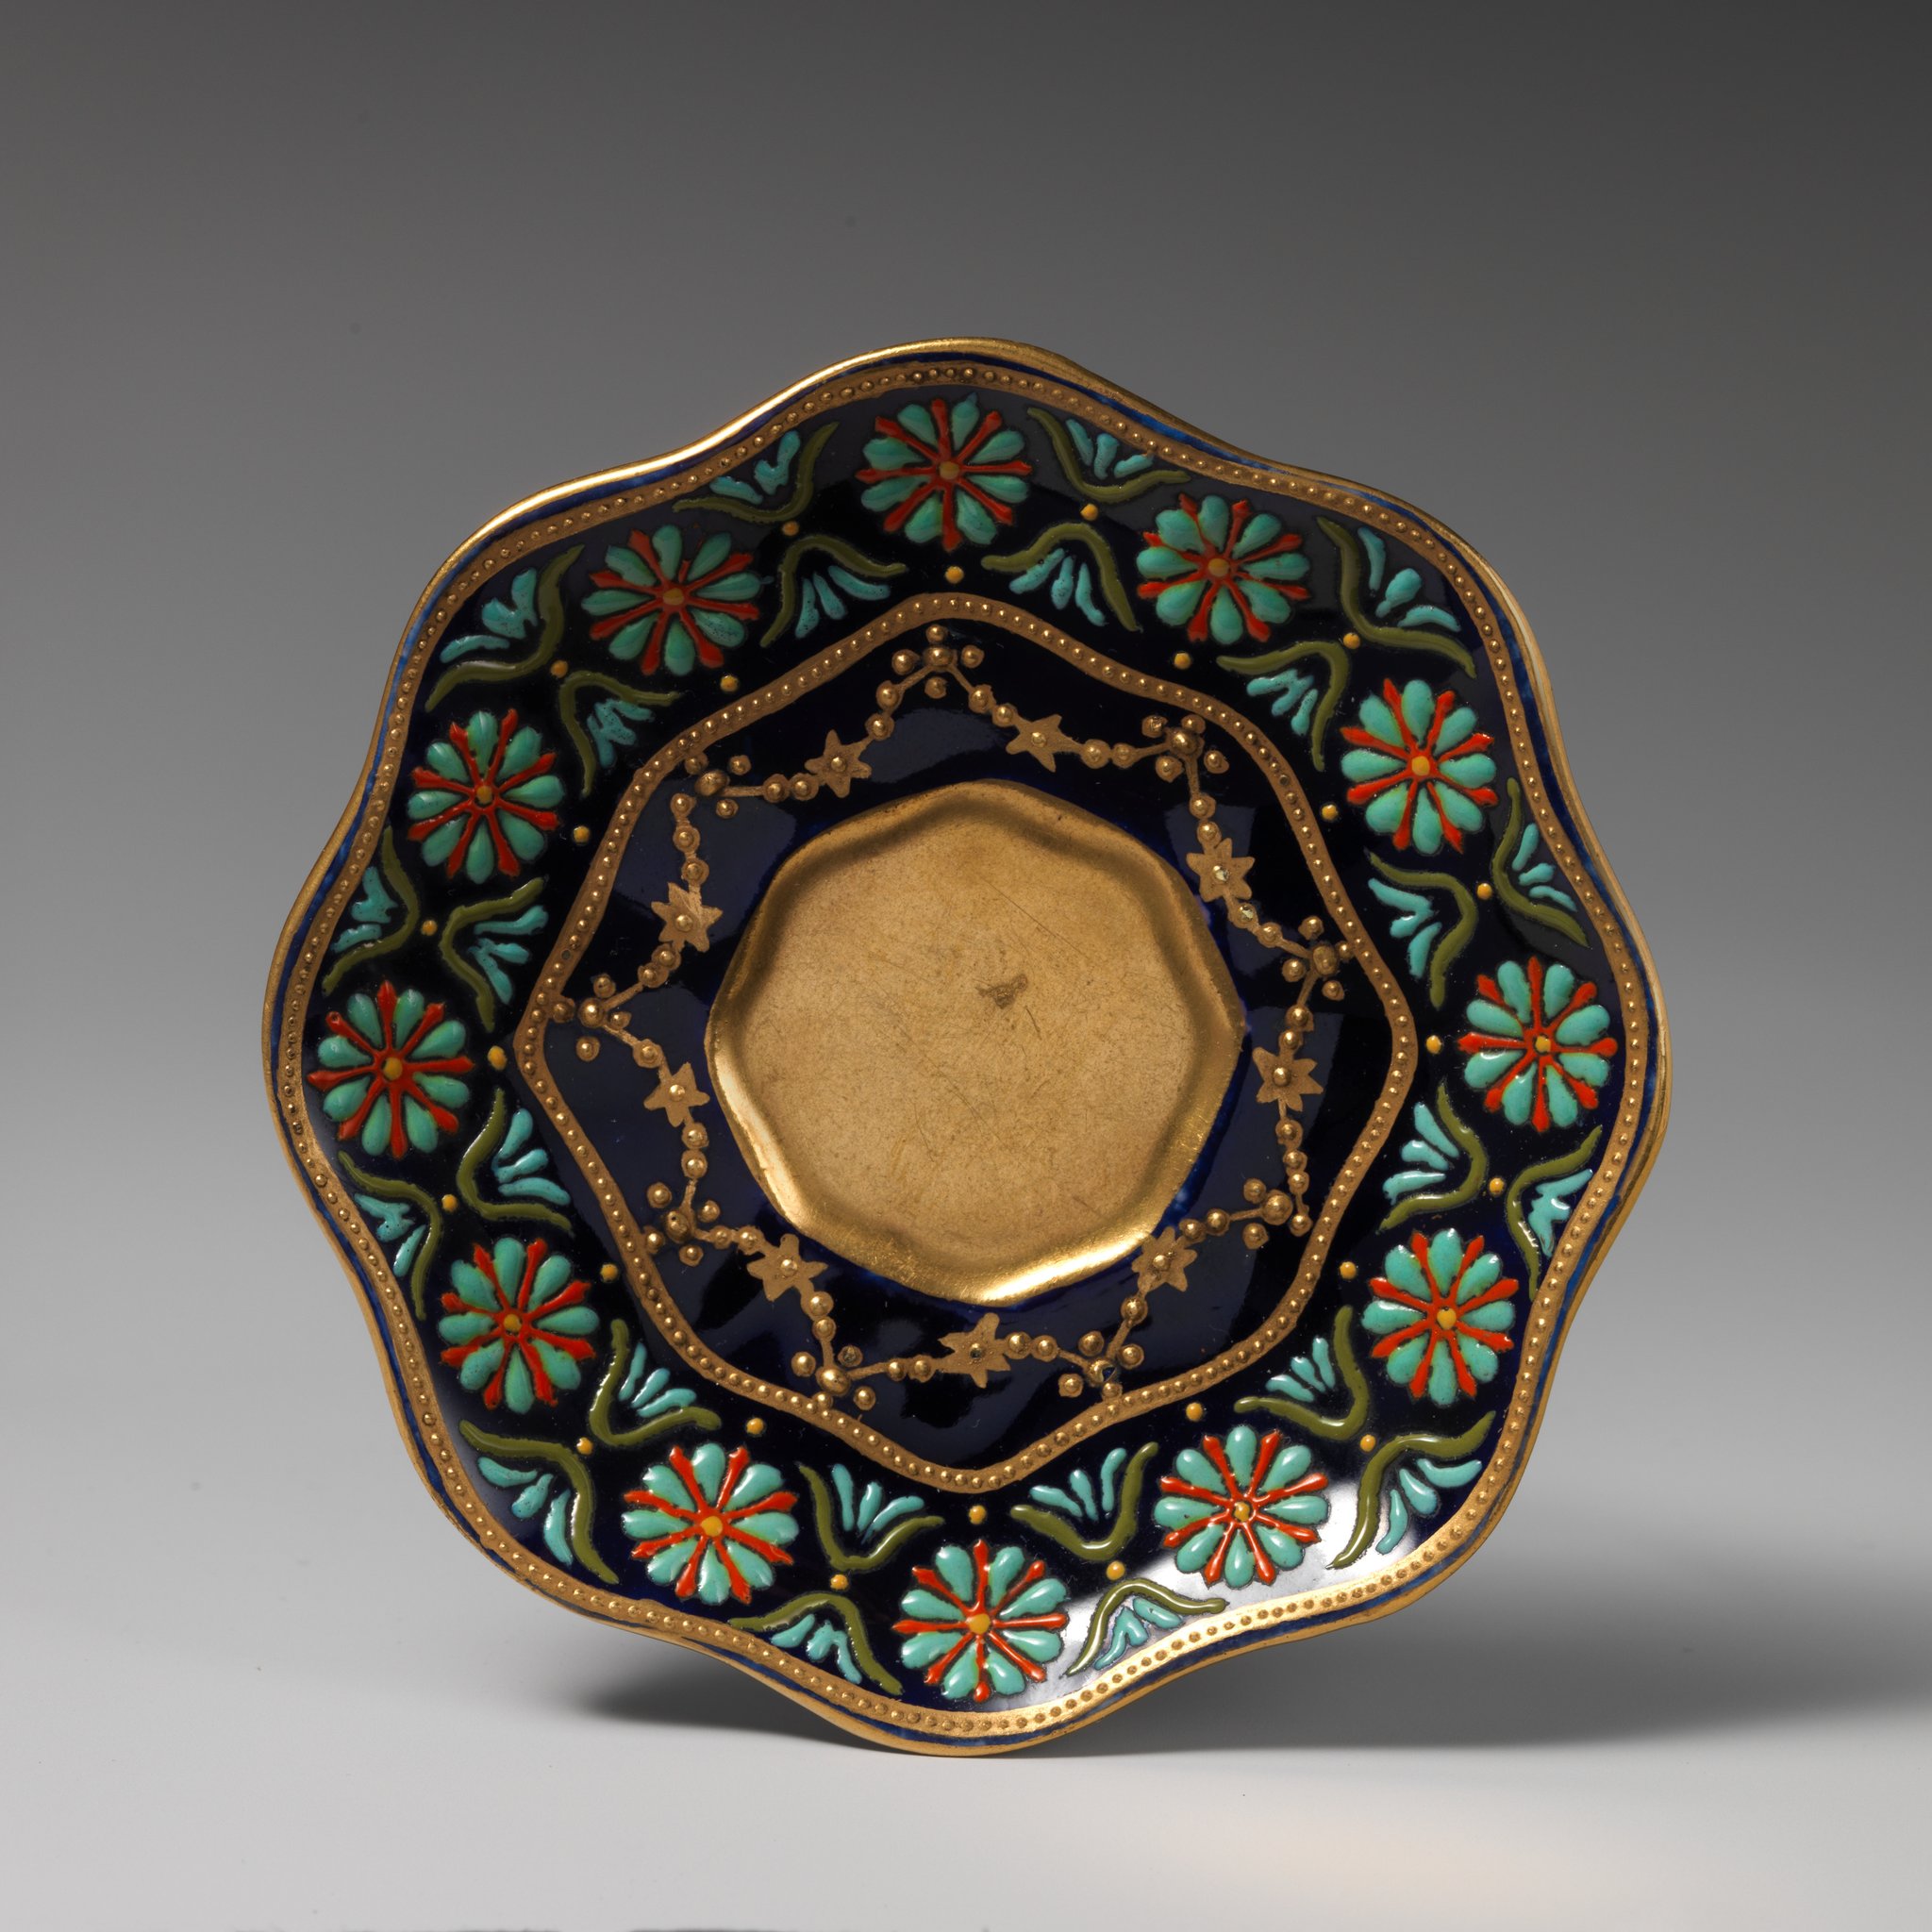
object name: saucer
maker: coalport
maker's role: maker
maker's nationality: british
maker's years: 1794-1926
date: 1881-1891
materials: porcelain